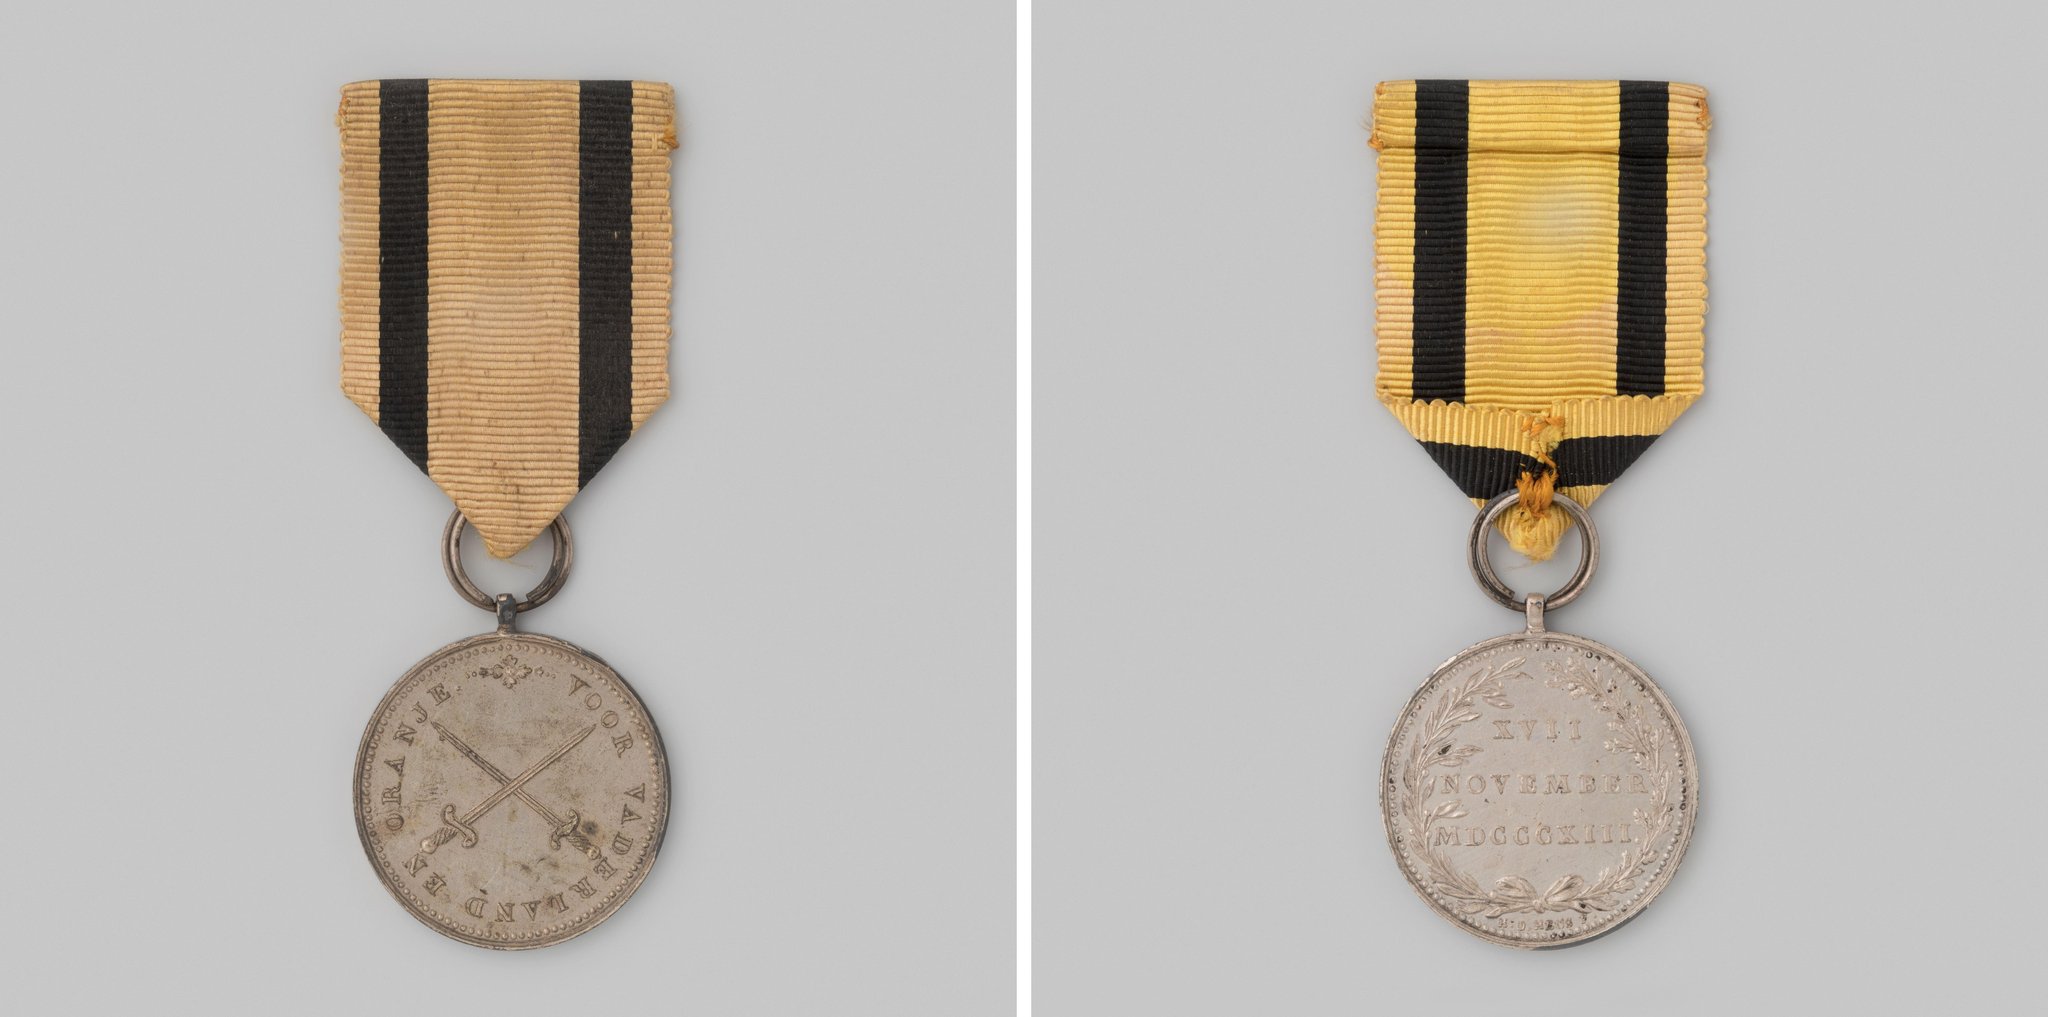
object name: honorary medal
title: Erepenning voor de Haagse vrijwilligers, bijgenaamd het Kanarievogeltje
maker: hendrik de heus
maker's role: medailleur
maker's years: -1838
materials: silver, textile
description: Zilveren draagpenning met oog, ring en lint, groot model.